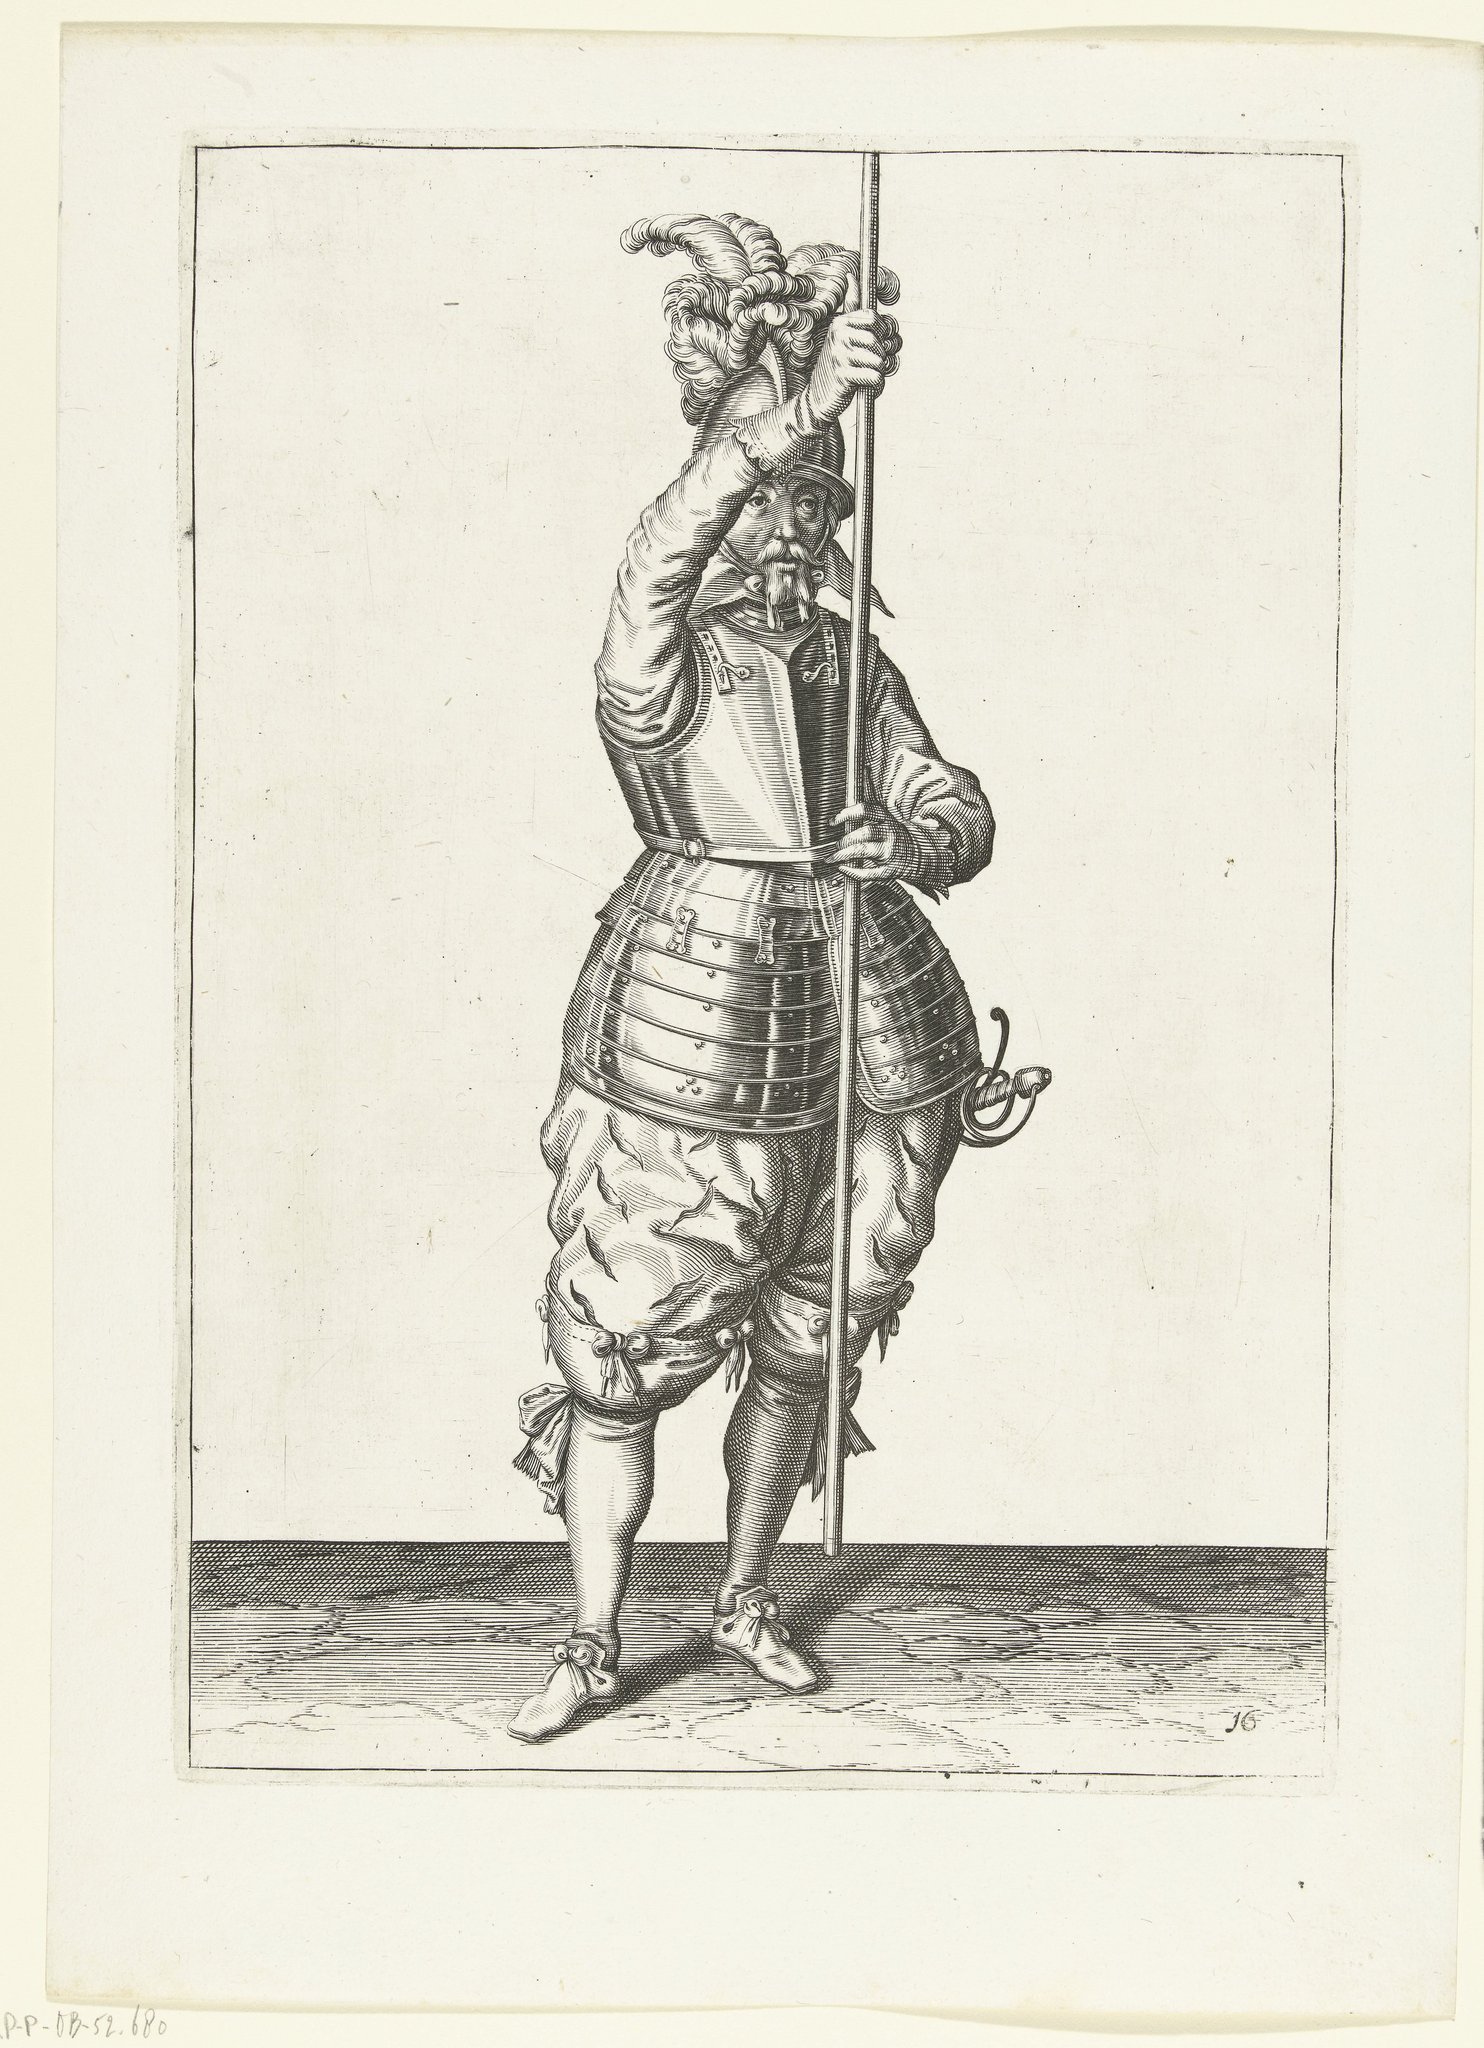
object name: print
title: Wapenhandelinghe van Roers Musquetten ende Spiessen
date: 1597-1607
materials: paper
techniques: engraving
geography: netherlands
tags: manoeuvre ~ military training, warfare; military affairs (+ mercenary troops, e.g.: lansquenets), helved weapons, polearms (for striking, hacking, thrusting): lance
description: Een soldaat, ten voeten uit, die een spies (lans) met beide handen rechtop voor zich iets boven de grond vasthoudt. Dit is de tweede handeling voor het op de grond plaatsen van de spies. Deze prent is onderdeel van de reeks van 32 genummerde prenten van spiesdragers uit de Wapenhandelinghe.